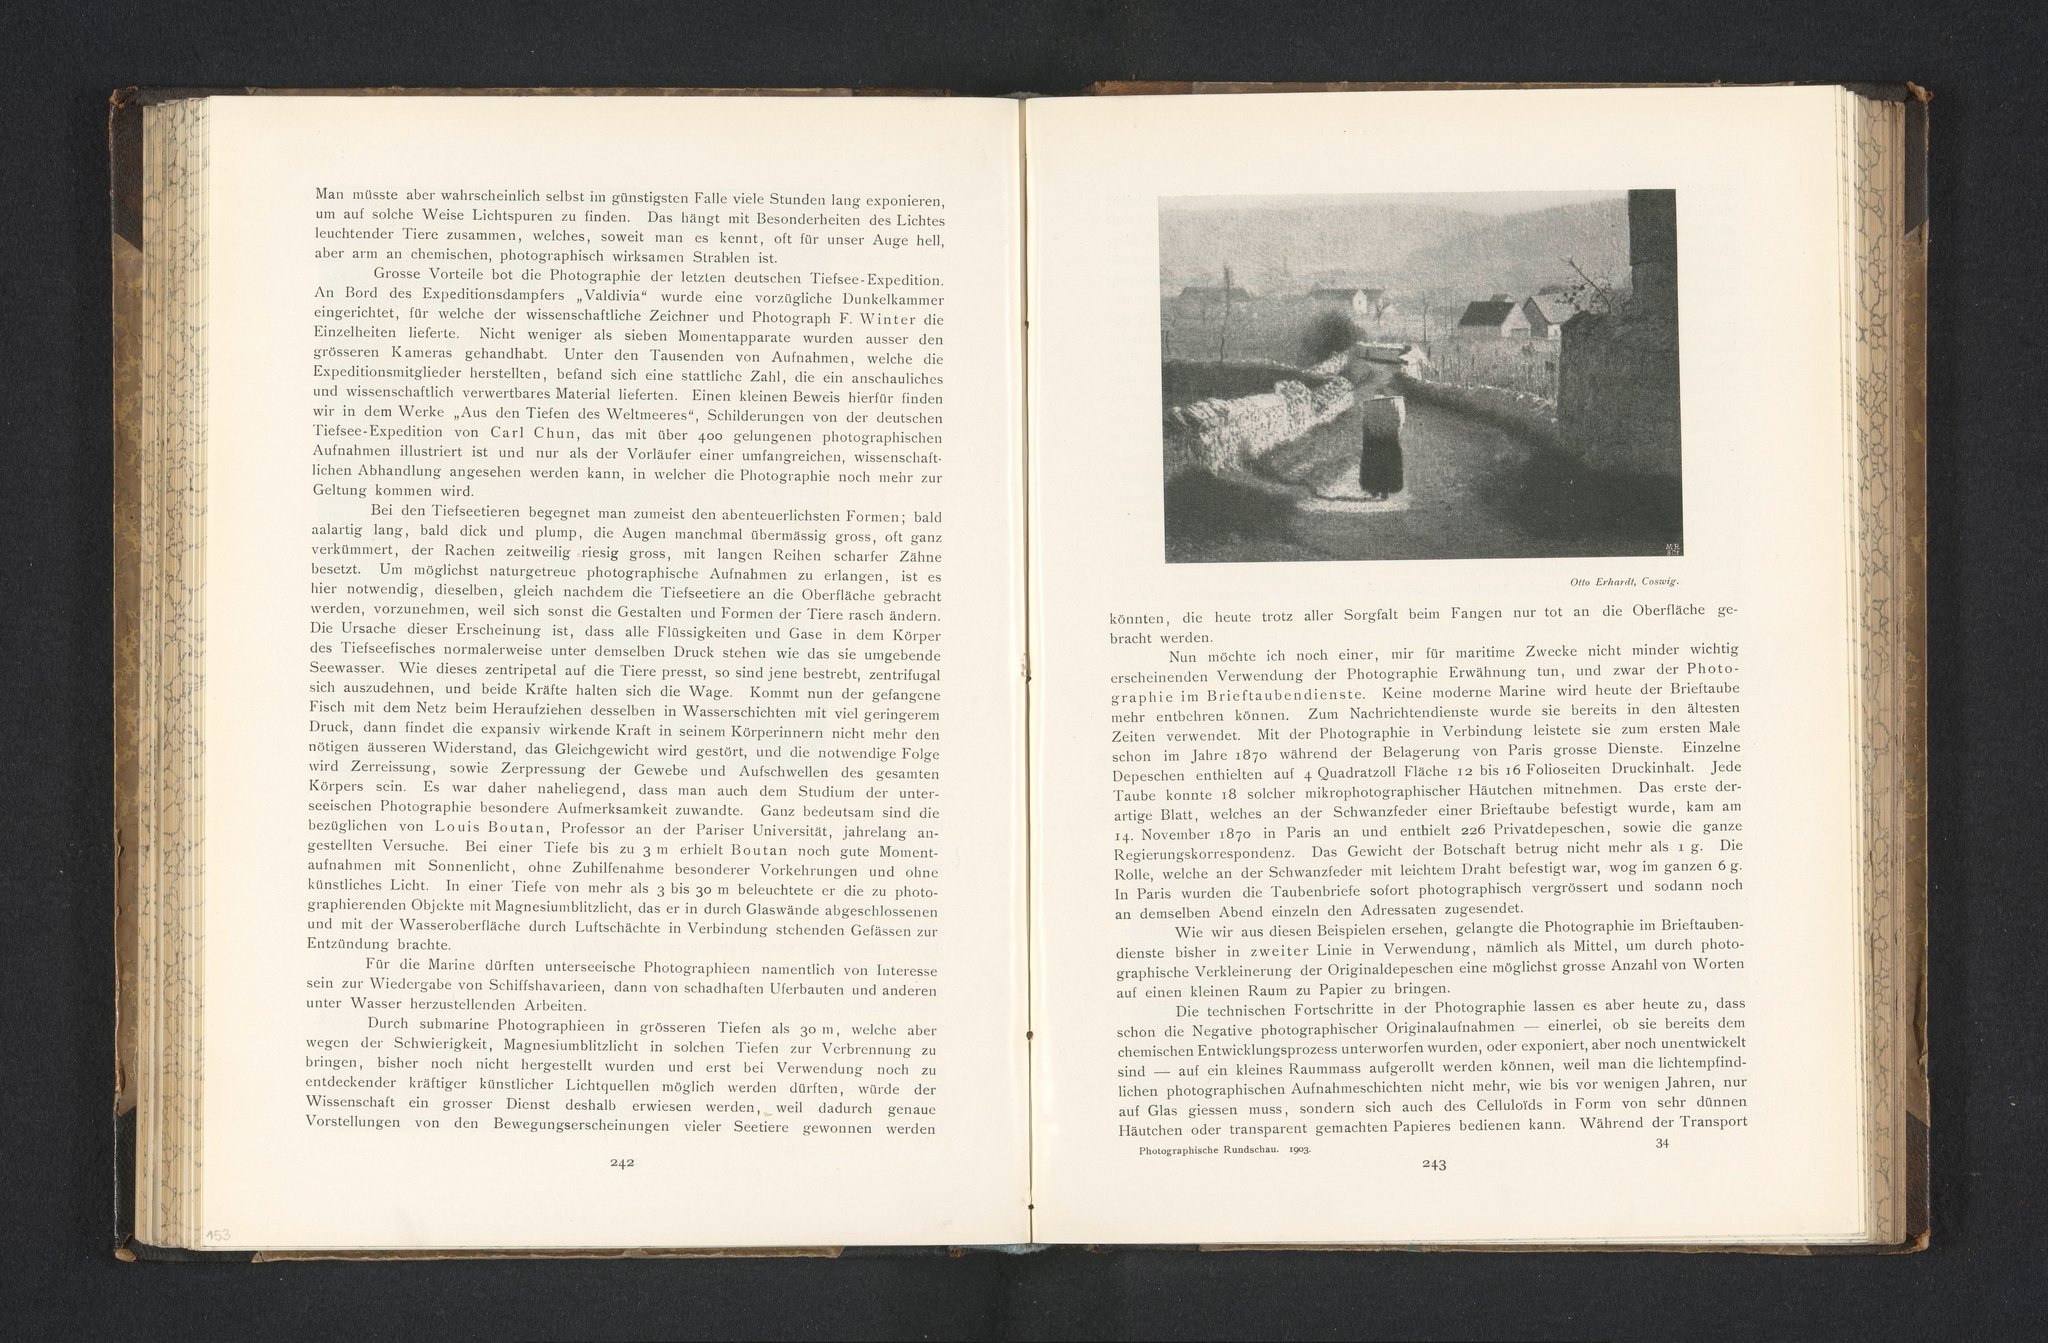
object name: photomechanical print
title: Gezicht op een persoon op een weg, met op de achtergrond huizen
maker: otto erhardt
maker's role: fotograaf, leraar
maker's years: 1869-1942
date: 1898-1903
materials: paper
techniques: autotype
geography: berlin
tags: housing, road, path